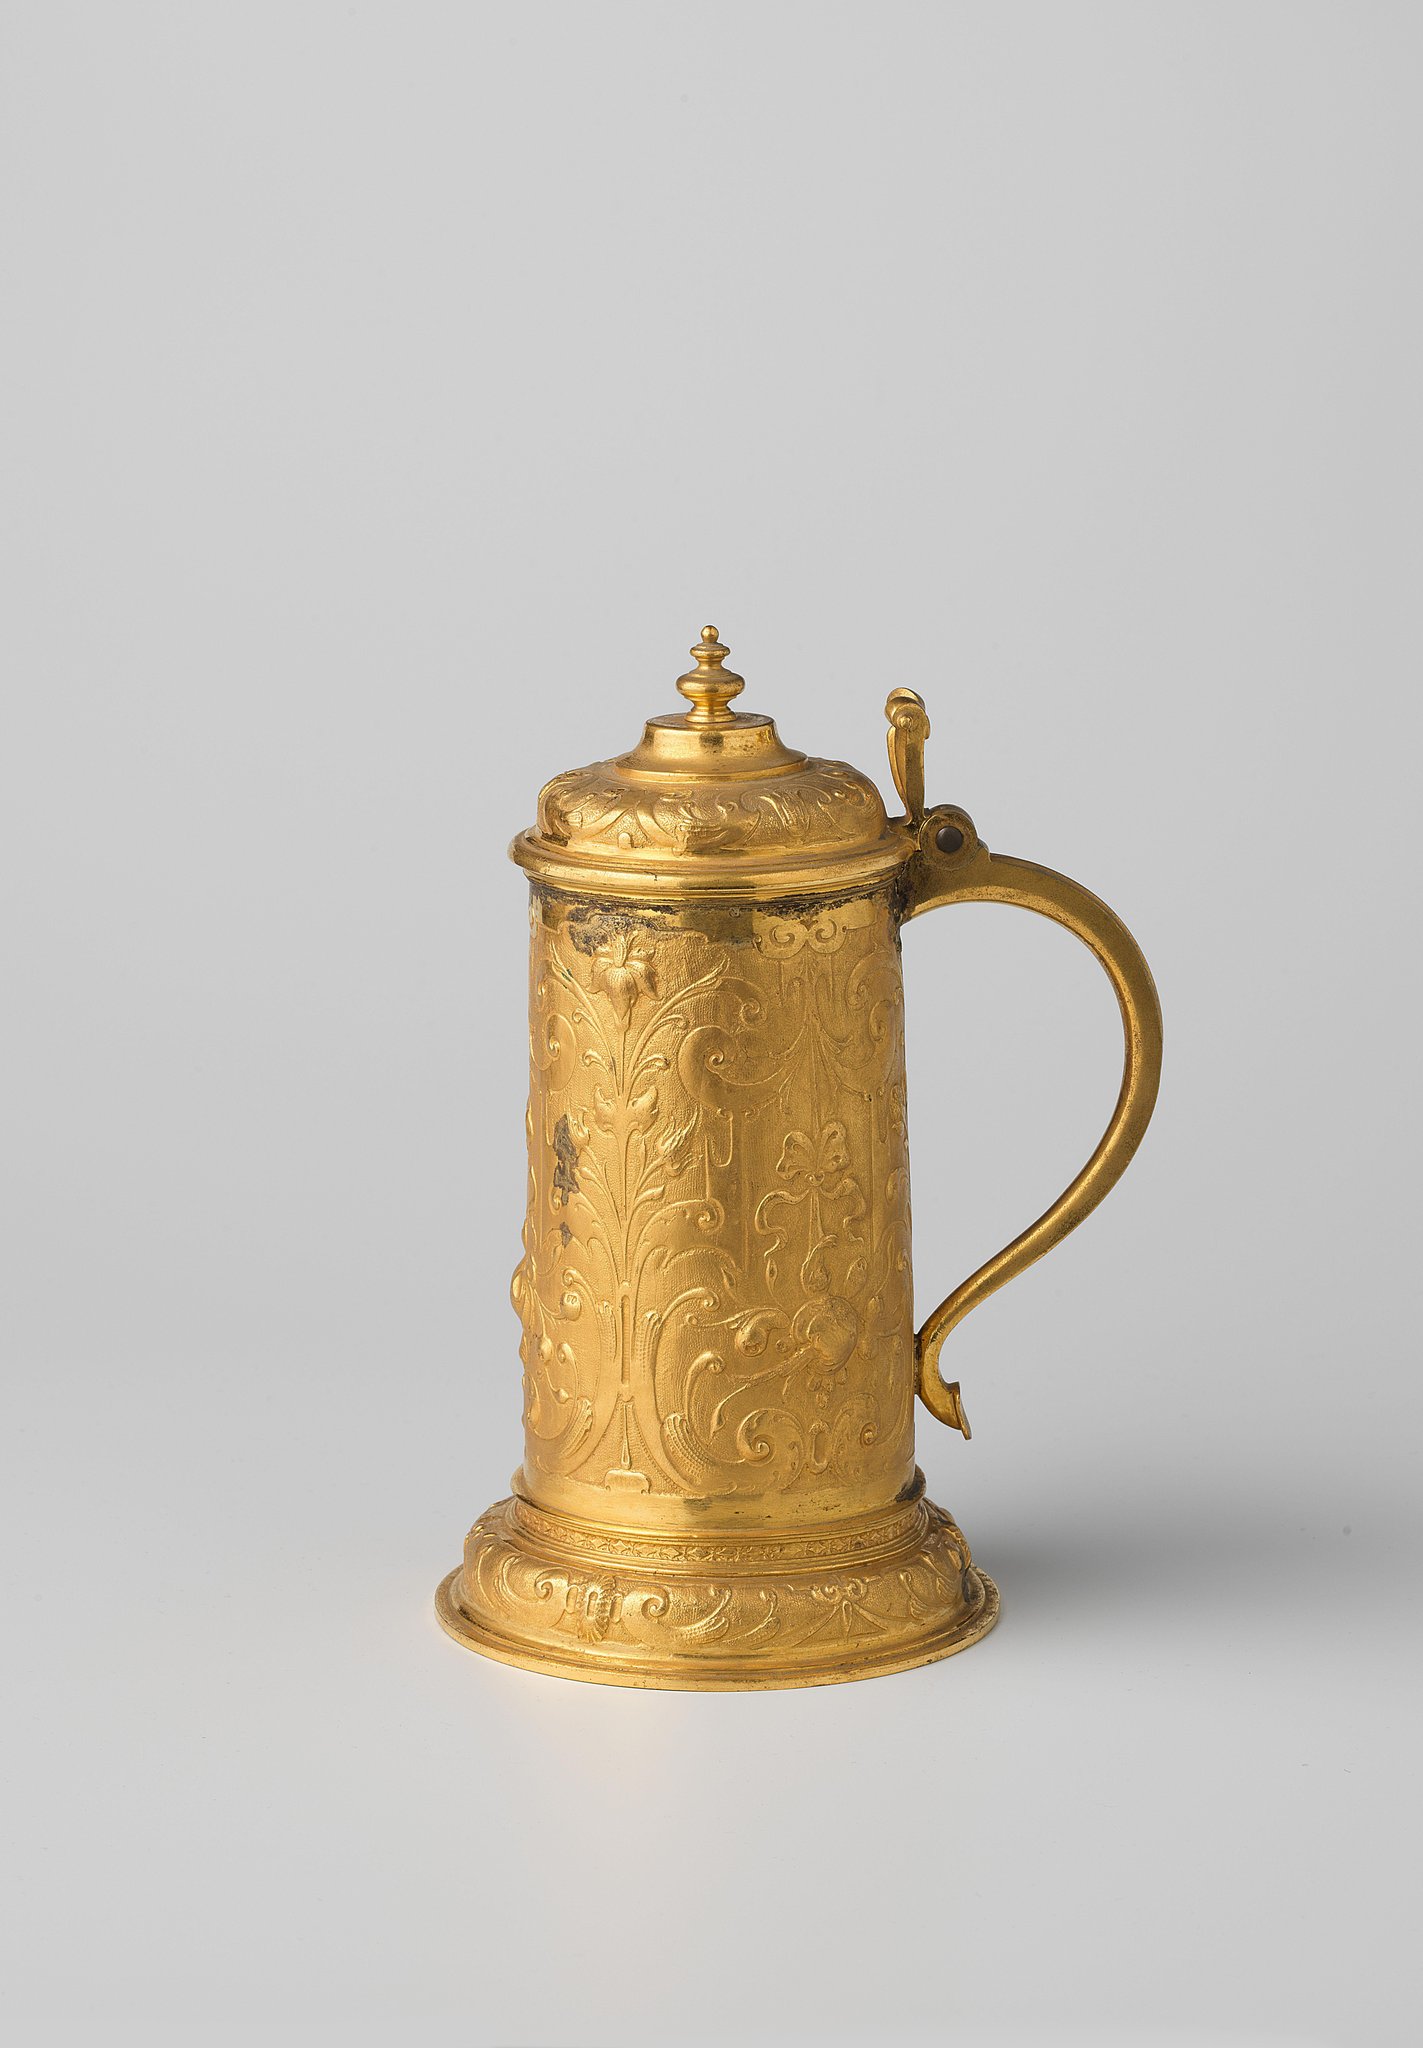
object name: drinkkan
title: Galvanoplastische reproductie van een drinkkan gedecoreerd met bloemen, vruchten en bandwerk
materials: copper, silver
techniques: gilding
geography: london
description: Galvanoplastische reproductie van een drinkkan gedecoreerd met gedreven bloemen, vruchten en bandwerk. Verguld.